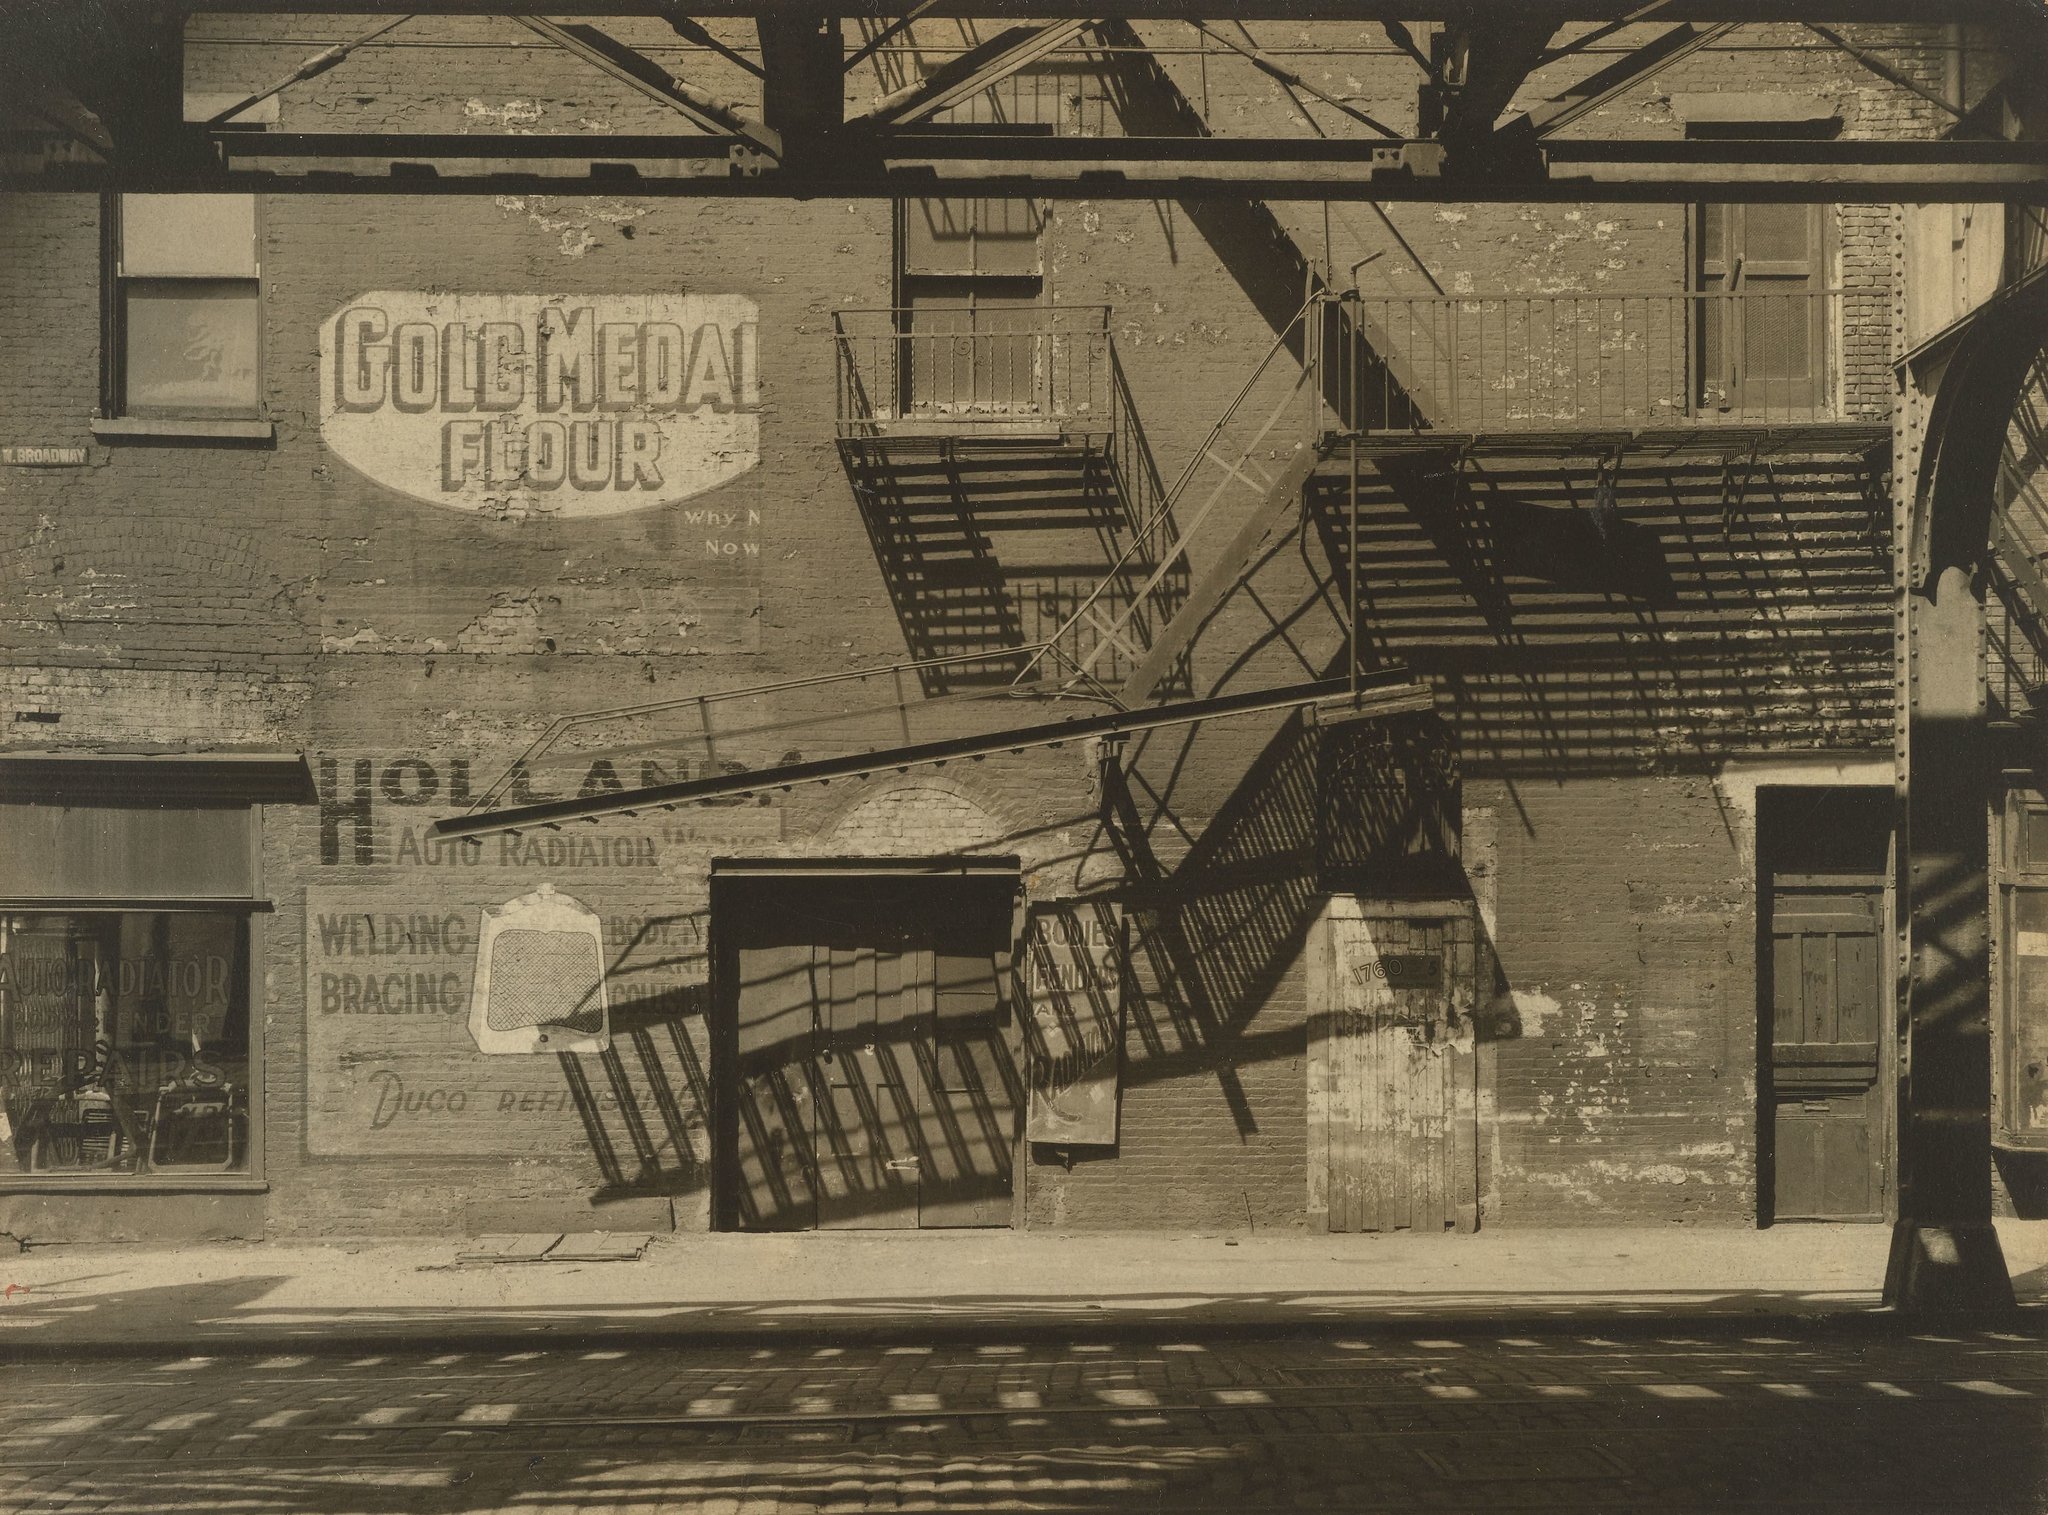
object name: photograph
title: Fire Escapes and Shadows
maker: peter sekaer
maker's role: fotograaf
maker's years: 1901-1950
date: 1935-1939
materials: paper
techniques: gelatin silver print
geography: new york city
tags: street, new york (city)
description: American documentary photography of the 1930s is generally recognized as one of the highlights of 20th-century photography. The work of Peter Sekaer, a lesser-known representative of this genre, was not about making ‘pretty pictures.’ Nevertheless, Sekaer occasionally gave in to the temptation of shooting studies of forms and details. He may have taken this photograph as part of an assignment while studying under the famous photographer Berenice Abbott.